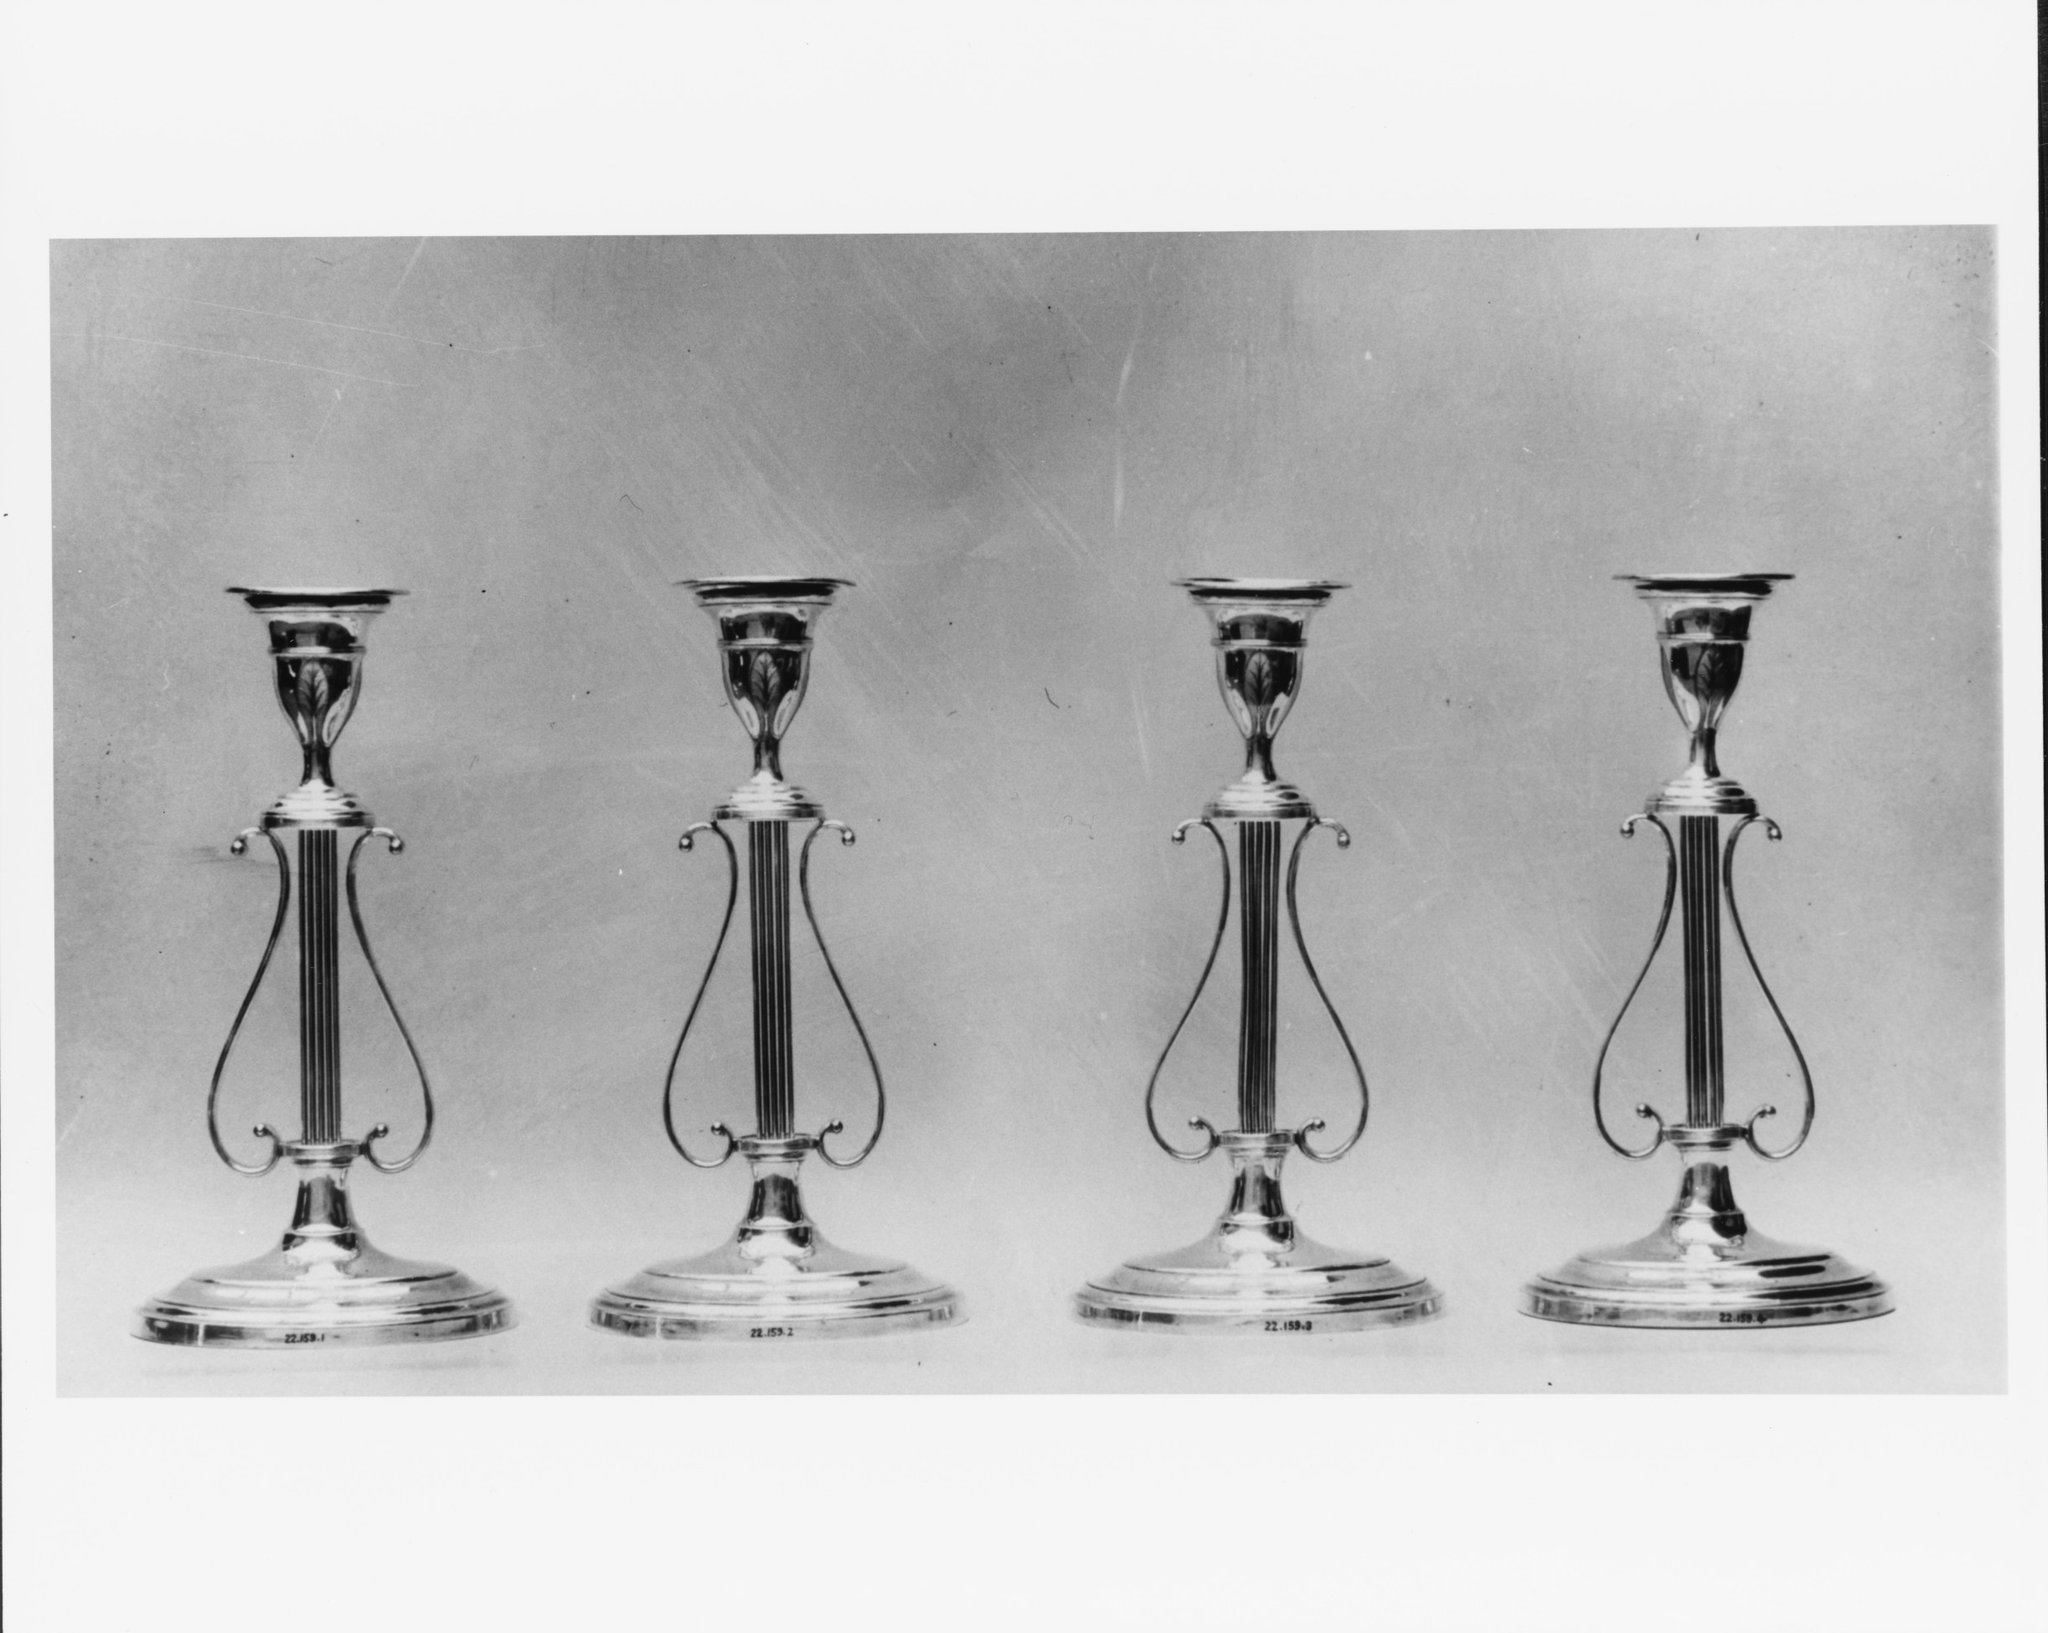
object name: candlestick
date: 1800-1830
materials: copper, silver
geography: england